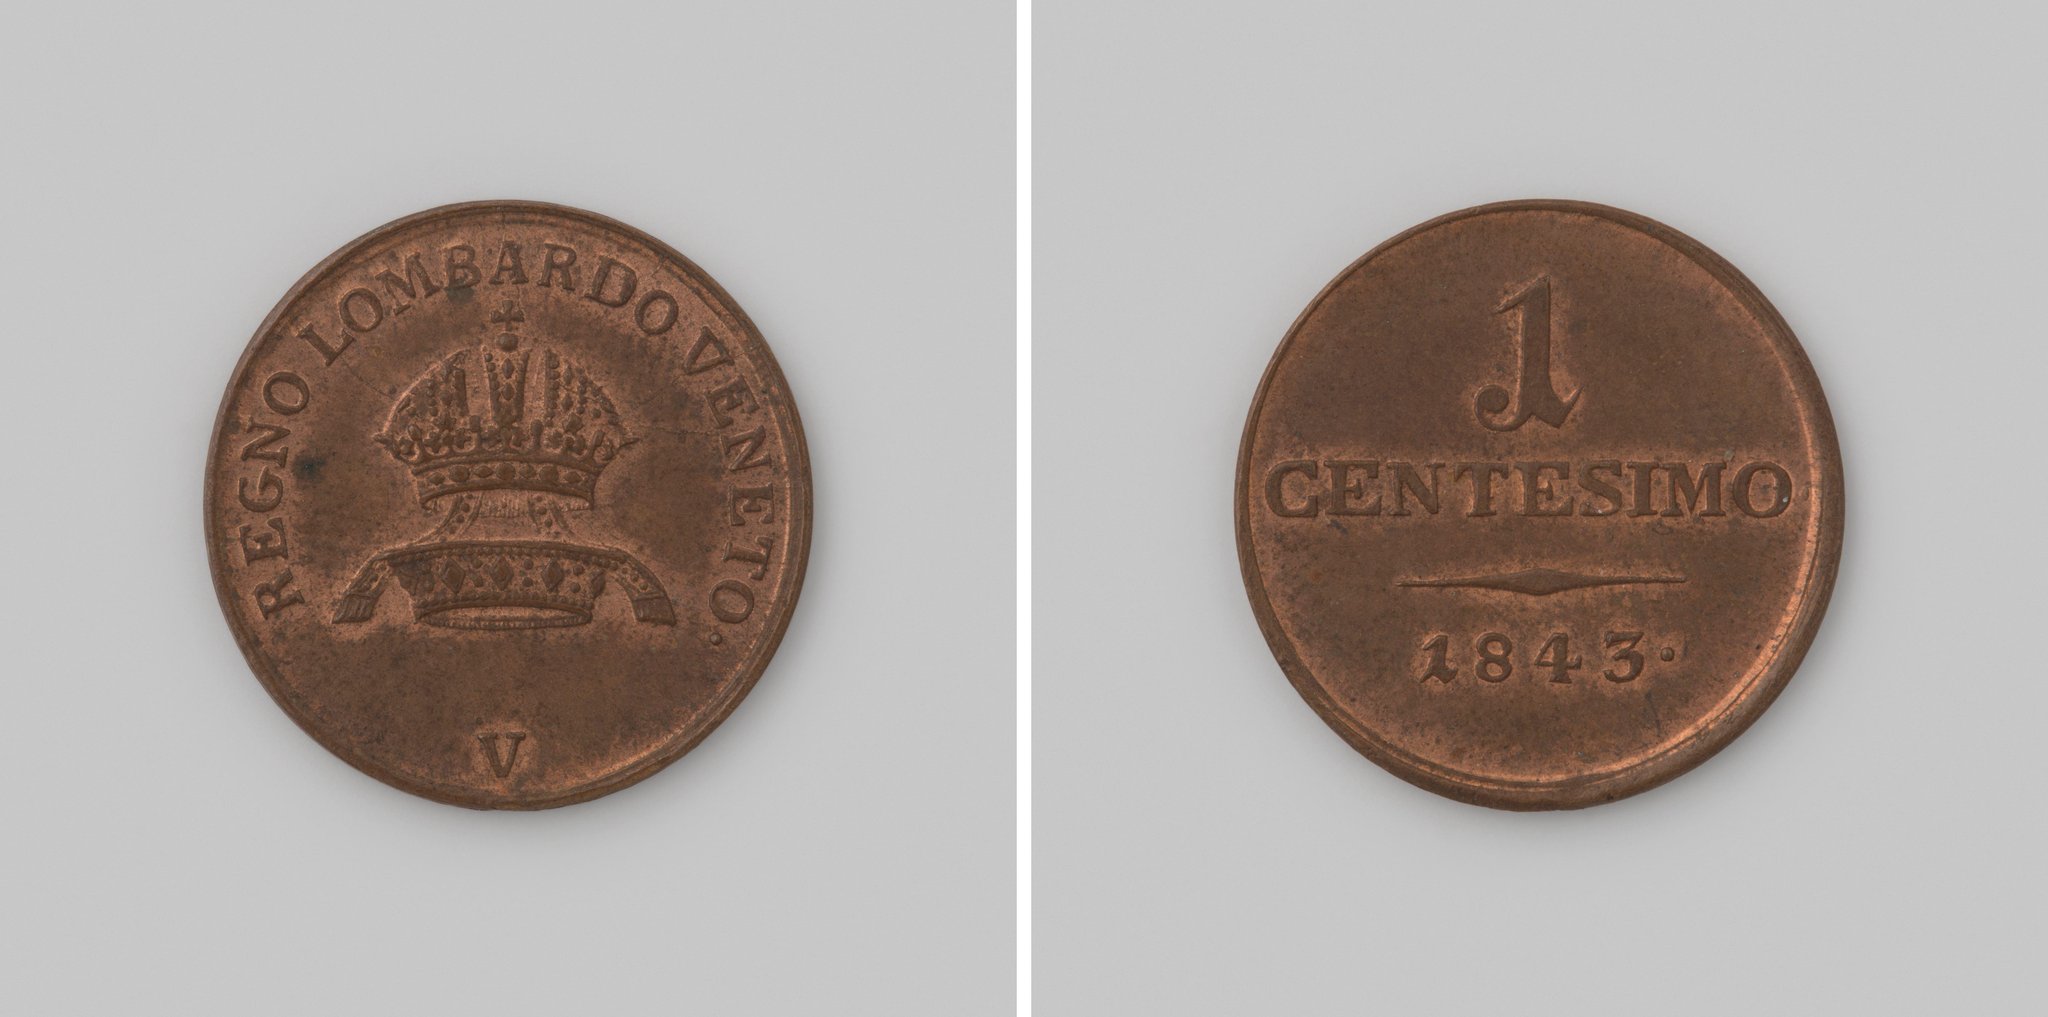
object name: coin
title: Oostenrijkse centesimo uit Lombardije-Venetië van keizer Ferdinand I, 1843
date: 1843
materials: copper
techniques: striking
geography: venice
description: Koperen munt. Voorzijde: keizerskroon met linten, waaronder kroon. Onderaan letter V [=Venetië]. Keerzijde: waarde-aanduiding in twee regels, waaronder jaartal. Gladde rand.